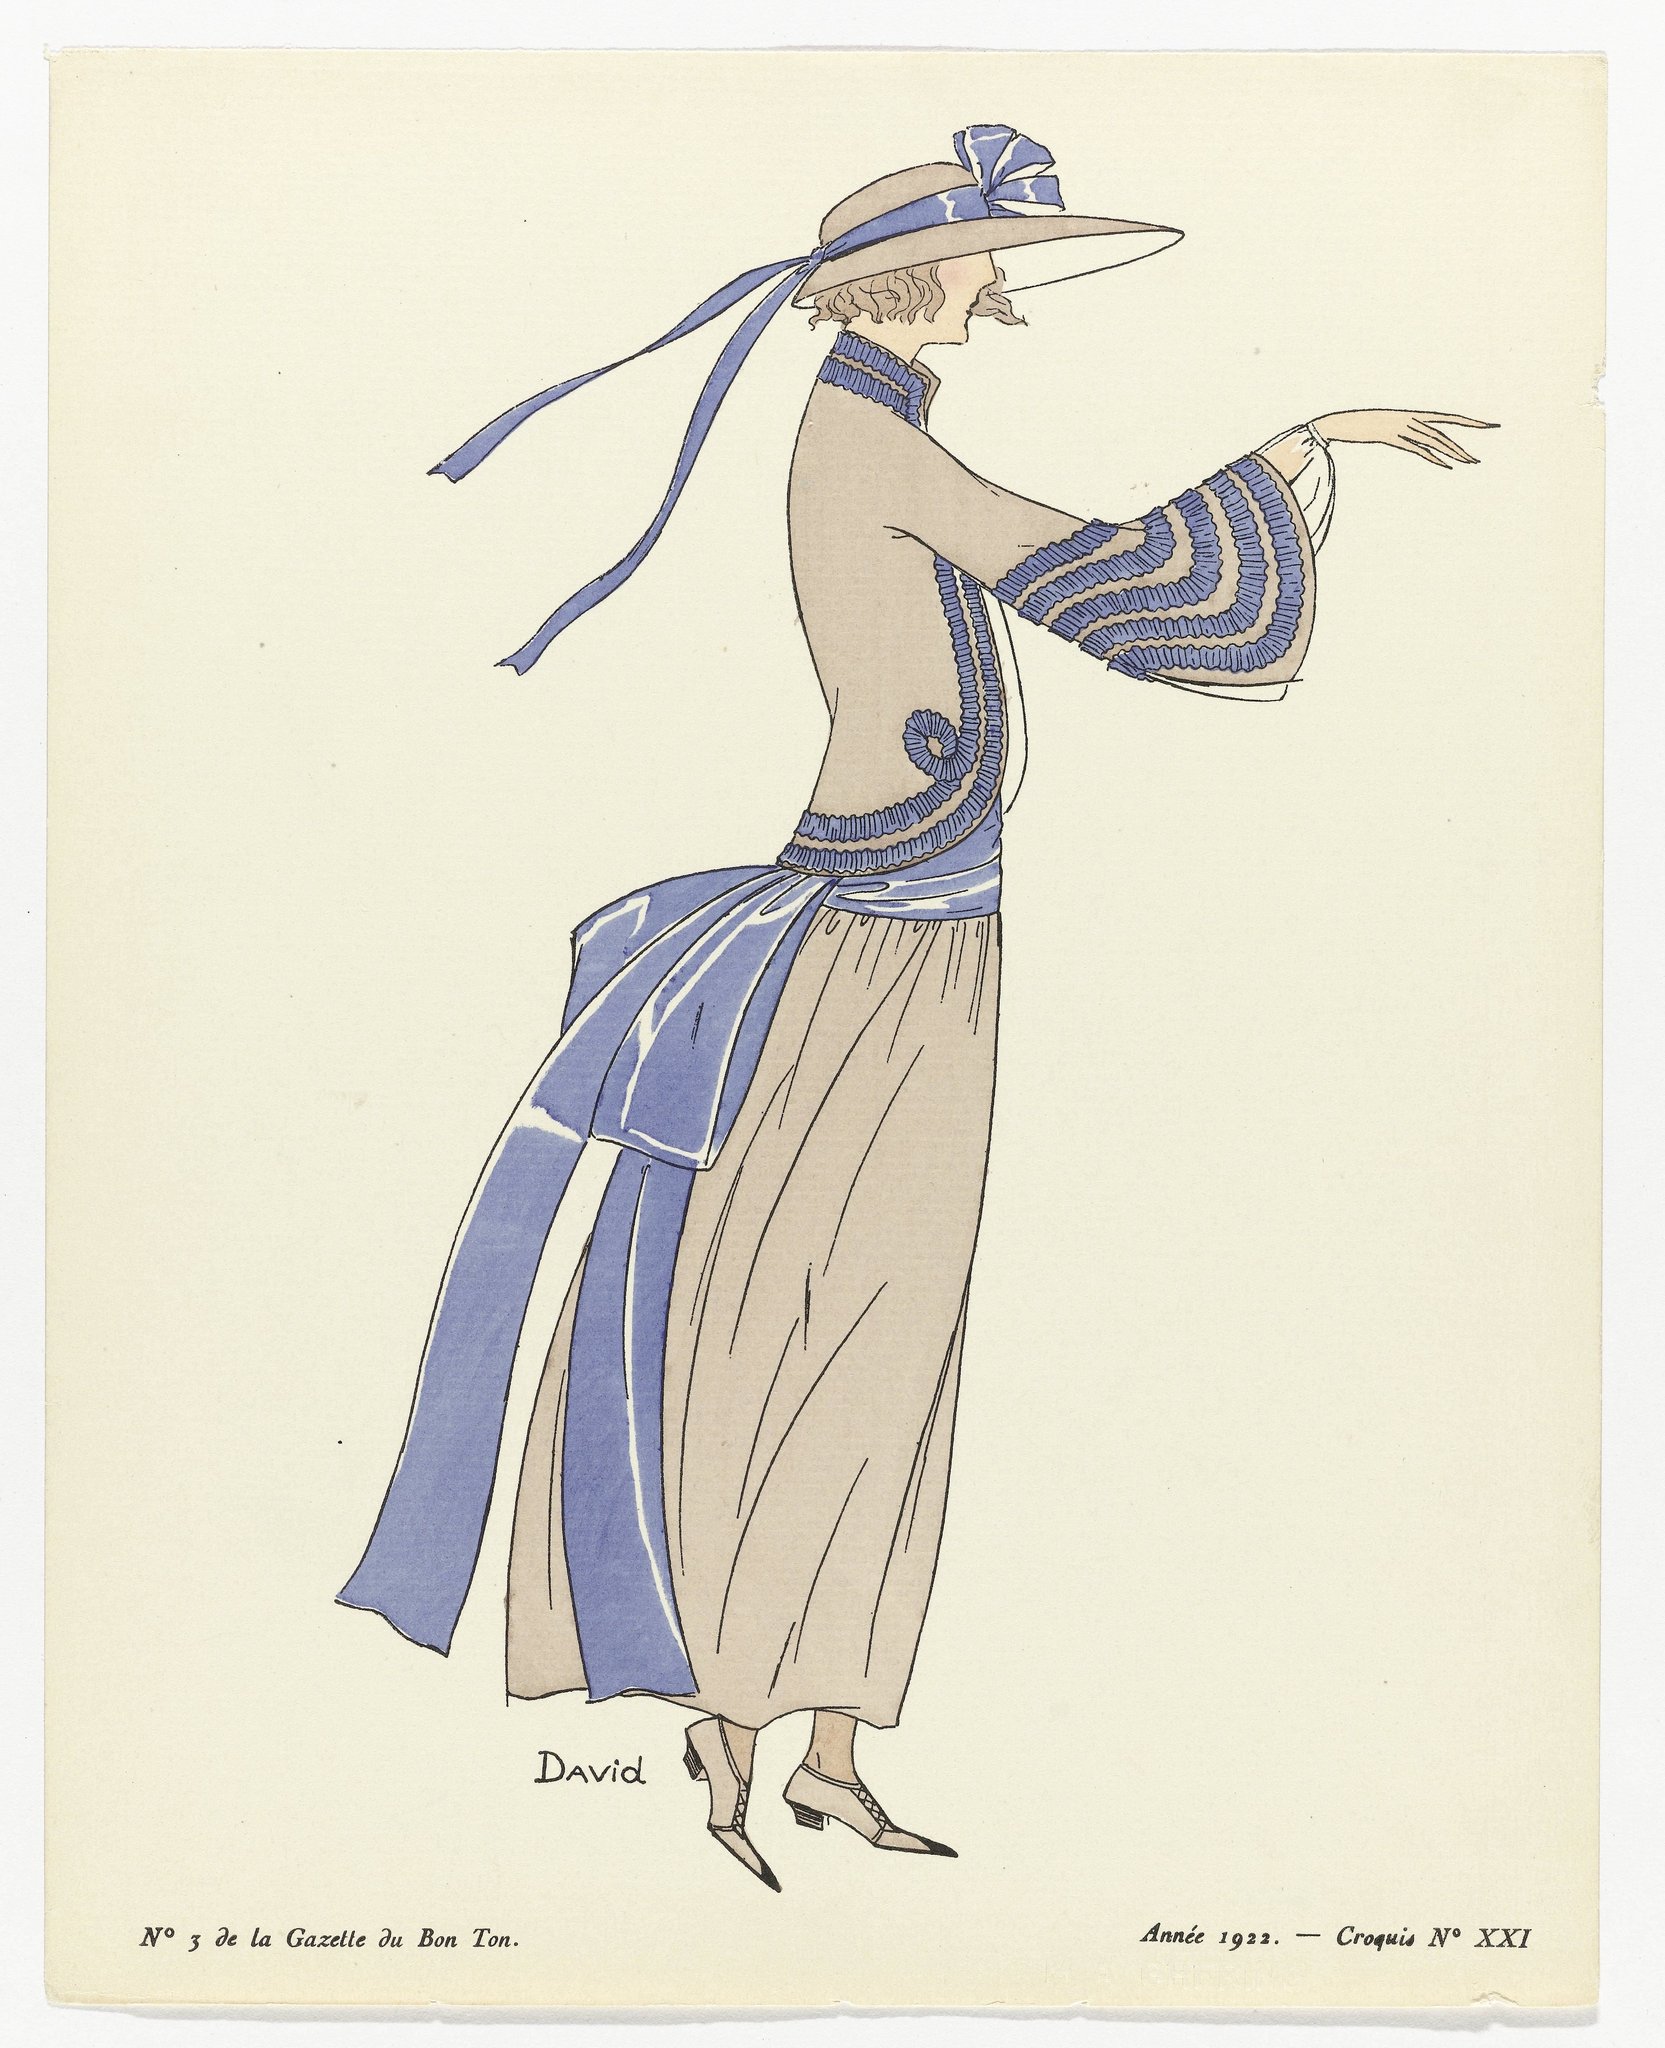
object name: fashion print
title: Gazette du Bon Ton, 1922, No. 3, Croquis No. XXI (21)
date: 1922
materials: paper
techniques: engraving, pochoir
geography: paris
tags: clothing for the upper part of the body (+ women's clothes), head-gear (+ women's clothes), fashion plates, skirt (+ women's clothes), belt, girdle, waistband (+ women's clothes)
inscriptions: title: ‘No 3 de la Gazette du Bon Ton. / Année 1922. - Croquis No XXI’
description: Kostuum met wijde mouwen en grote strik op de rug. Hoed met brede rand, versierd met een lint. Prent uit het modetijdschrift Gazette du Bon Ton (1912-1925).